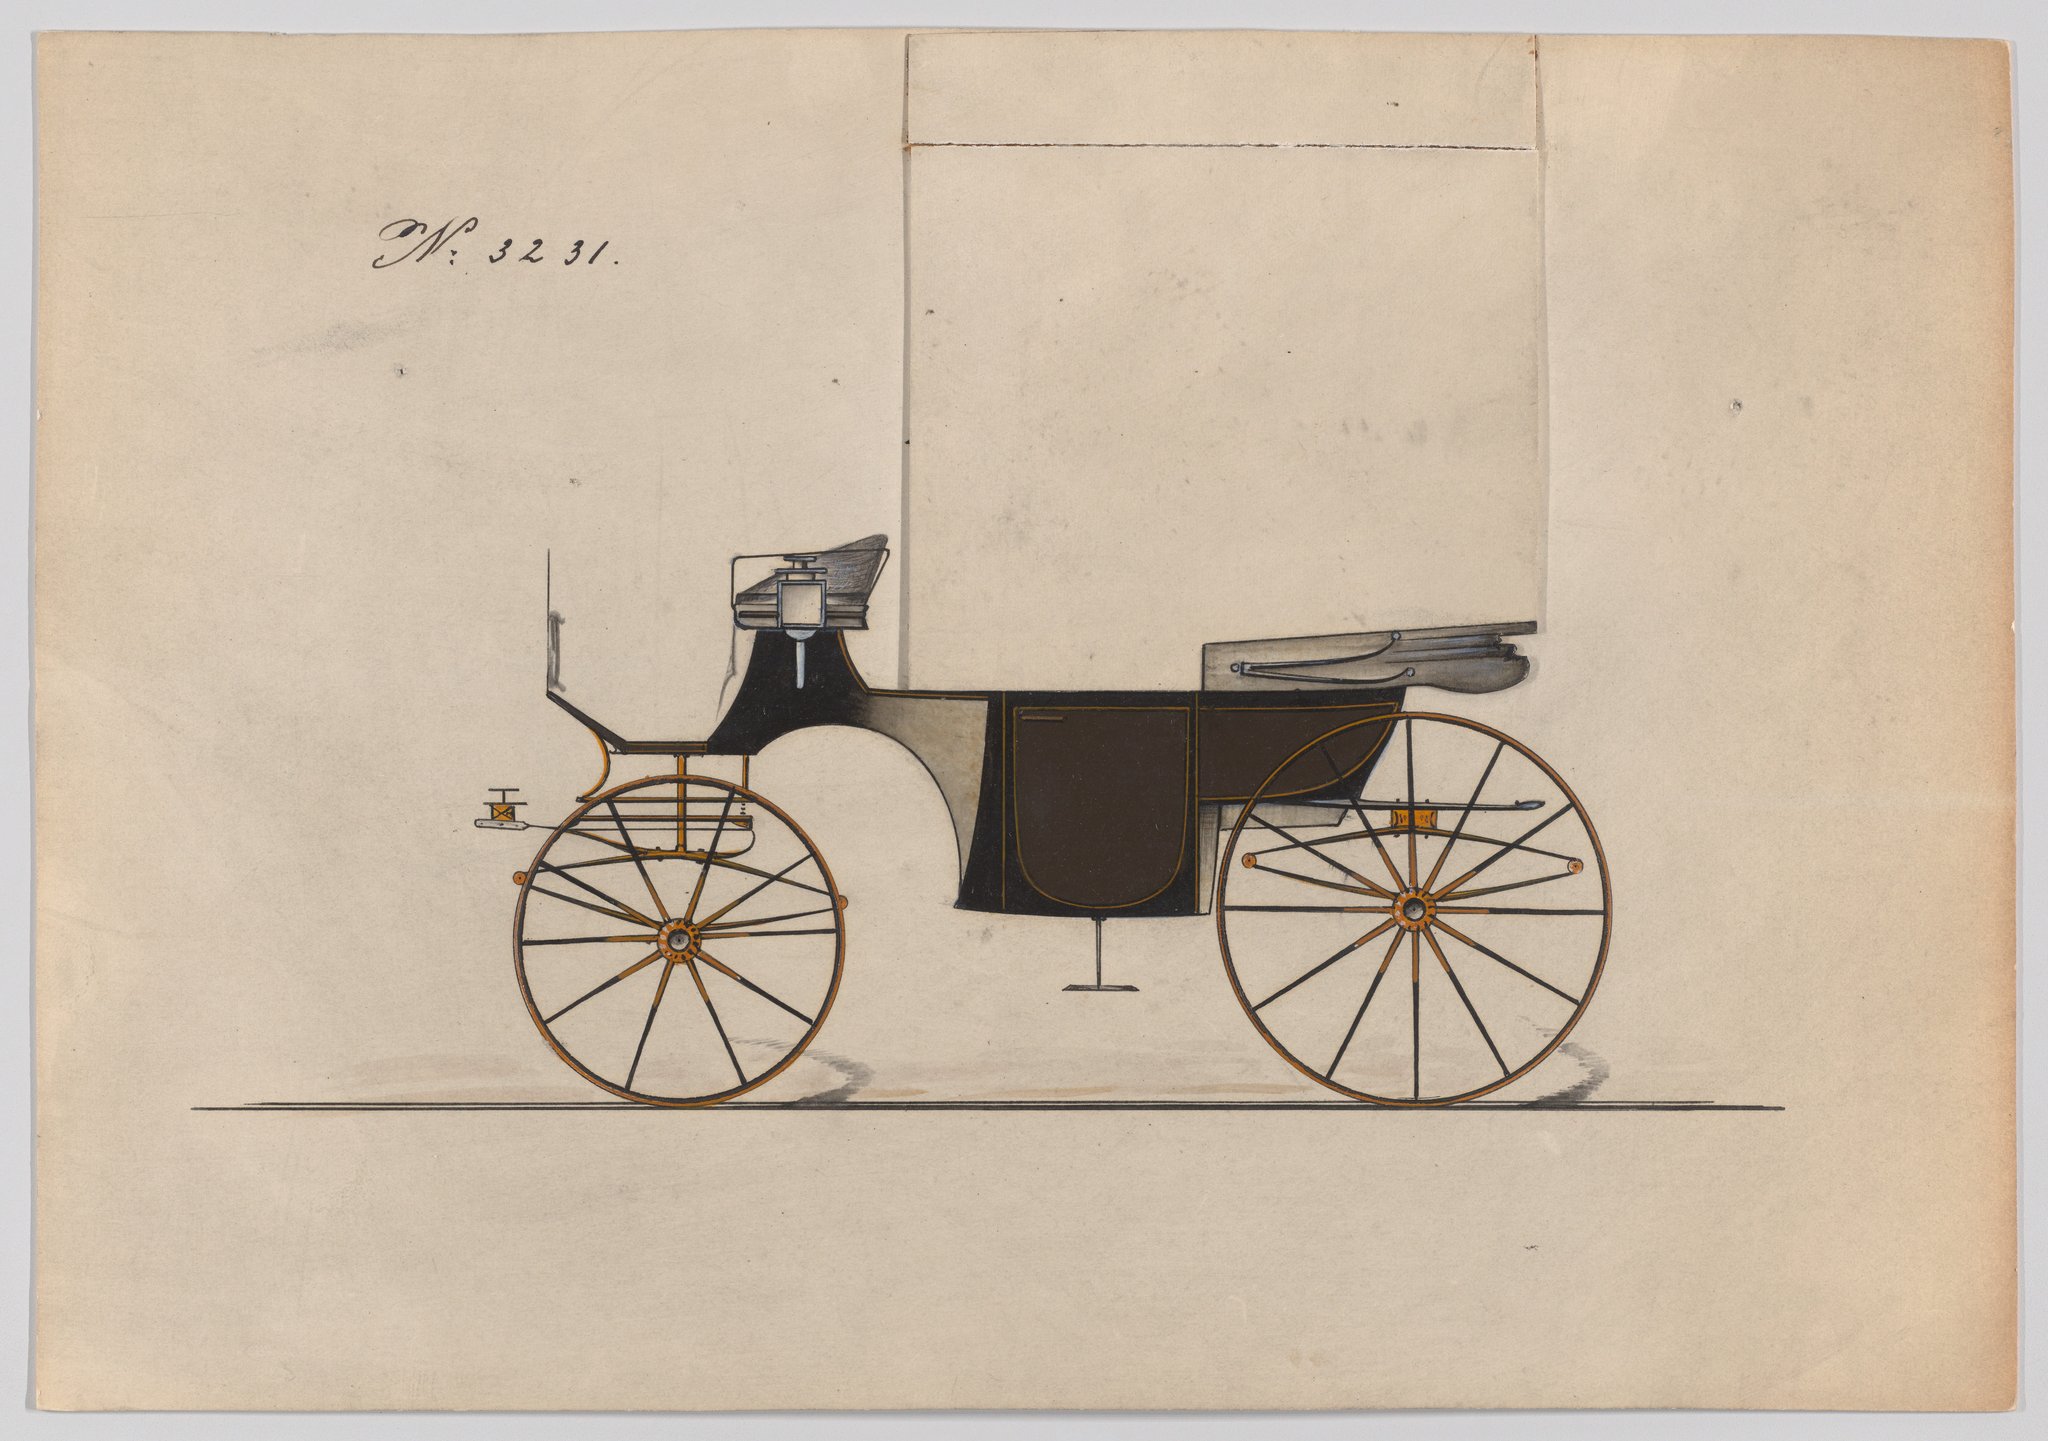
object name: drawing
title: Landaulet # 3231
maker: brewster & co.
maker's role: manufacturer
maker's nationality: american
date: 1876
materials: gouache, gum arabic, ink, watercolor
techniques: pen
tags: carriages